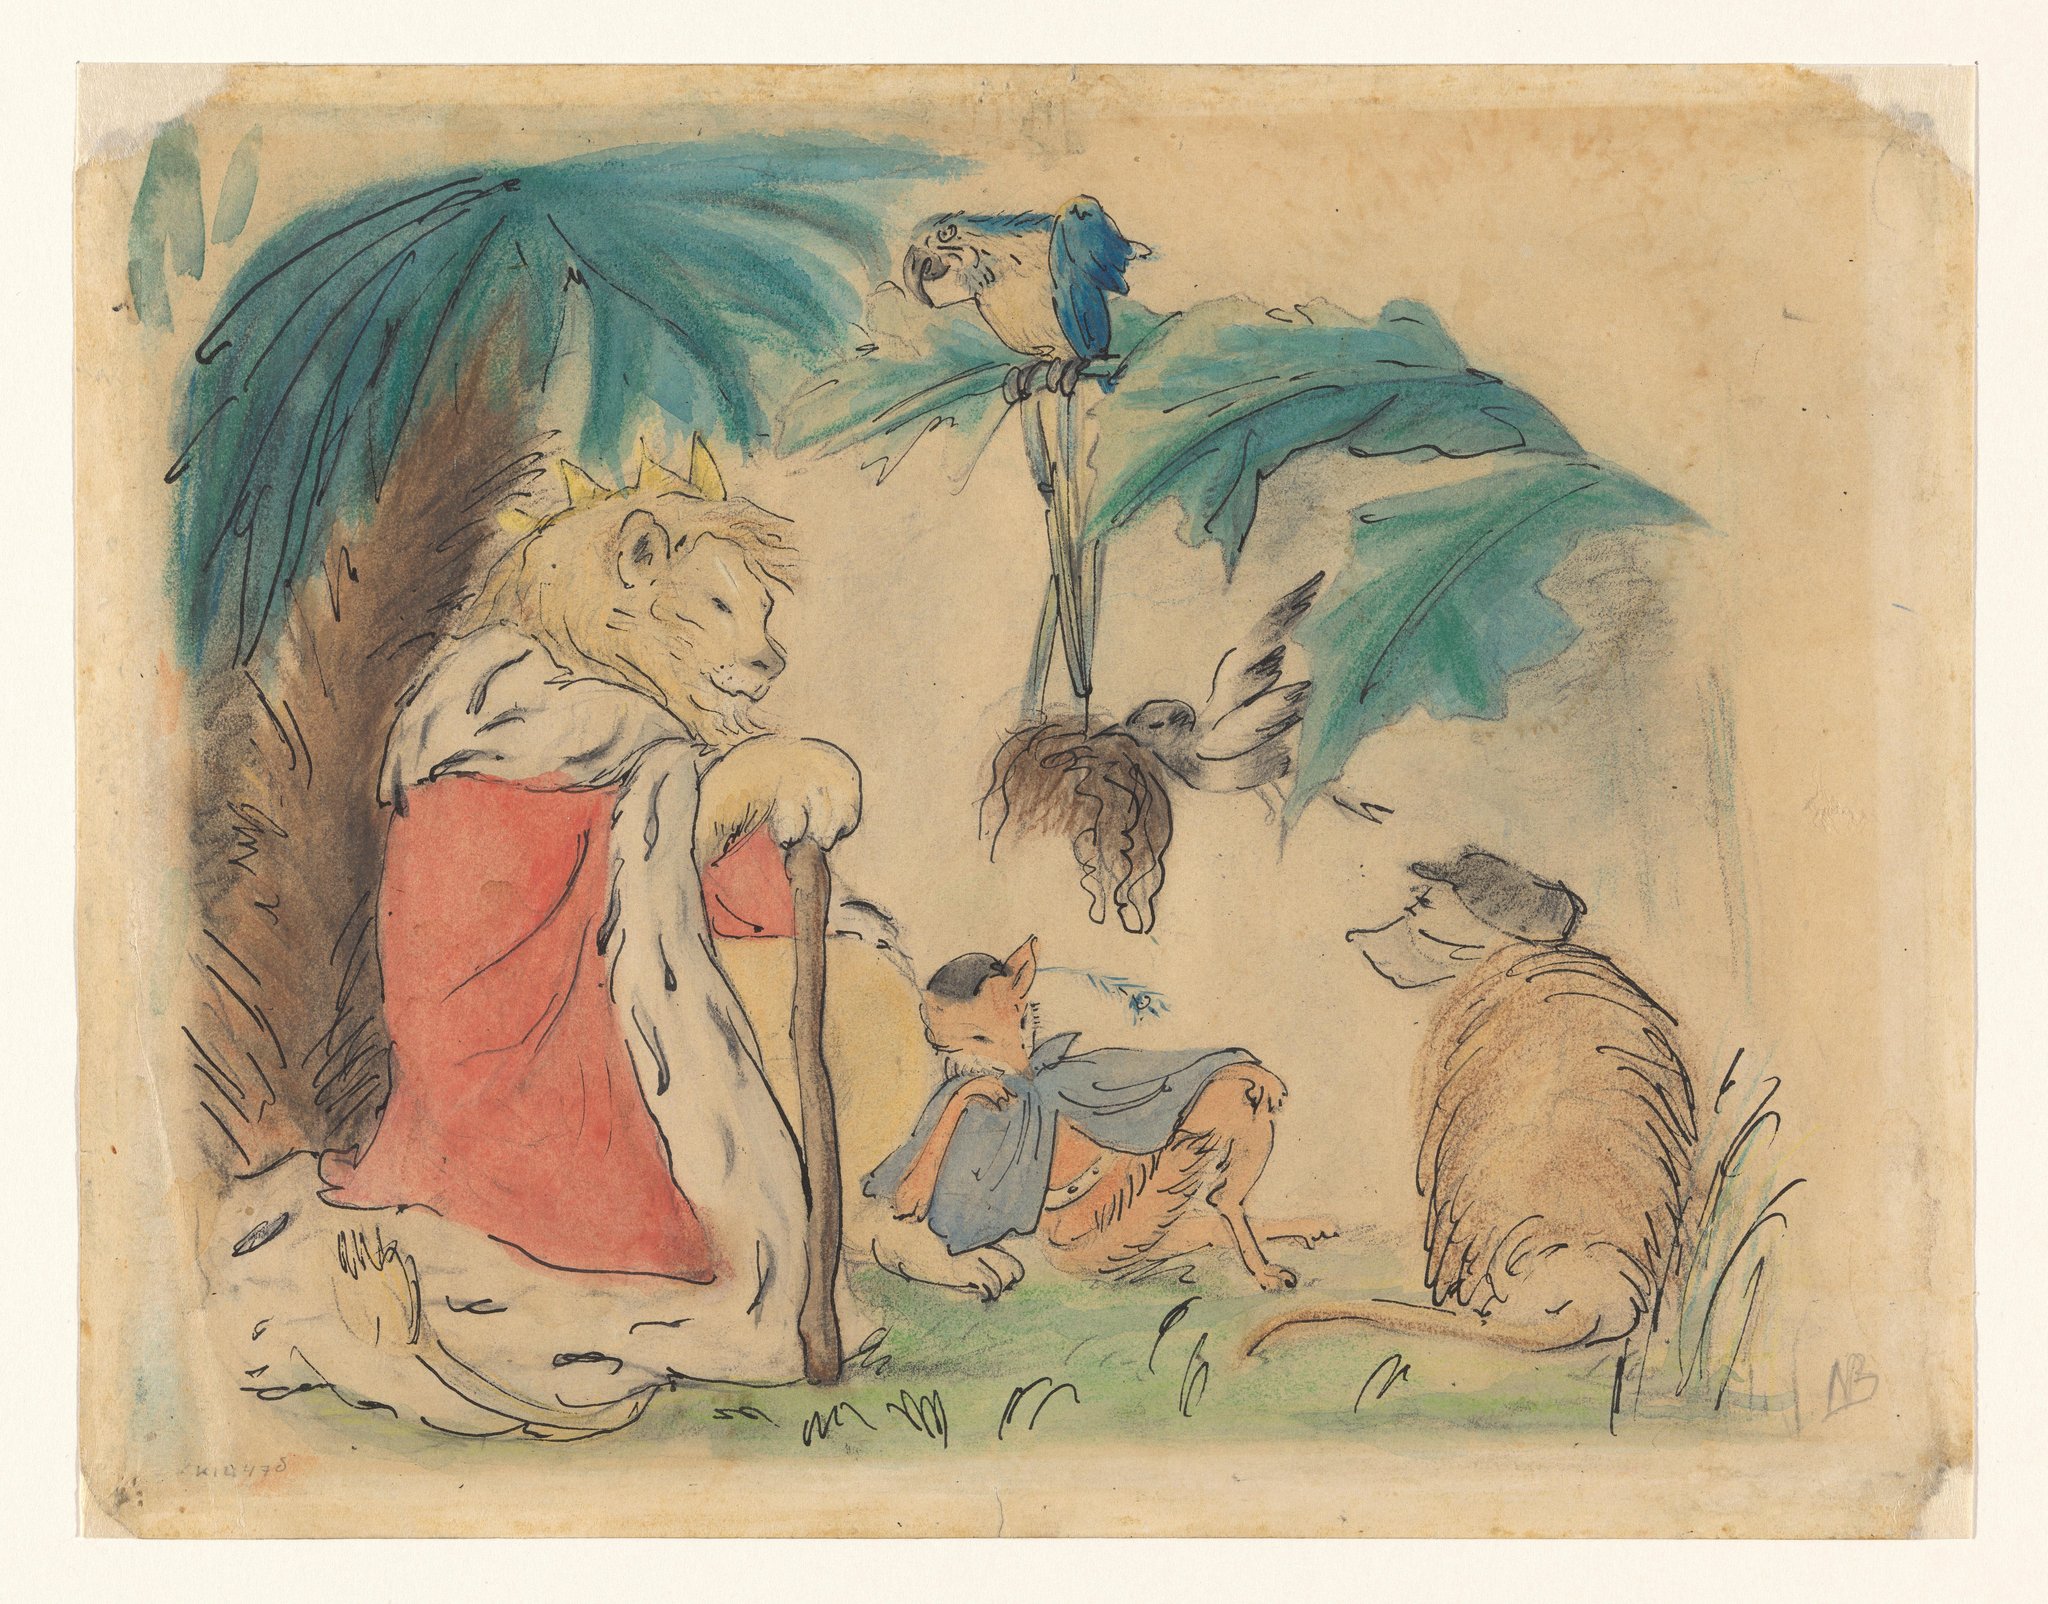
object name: drawing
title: Koning Leeuw ontvangt de pruik van oom Cassander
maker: nelly bodenheim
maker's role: designer, draughtsman, print maker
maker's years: 1874-1951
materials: ink, paper, pencil, watercolor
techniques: brush, pen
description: Omringd door de papegaai, zijn hofnar, de vos, zijn eerste minister en zijn lakei de aap ontvangt Koning Leeuw van de ekster de pruik van oom Cassander als geschenk van Vogel Rok.